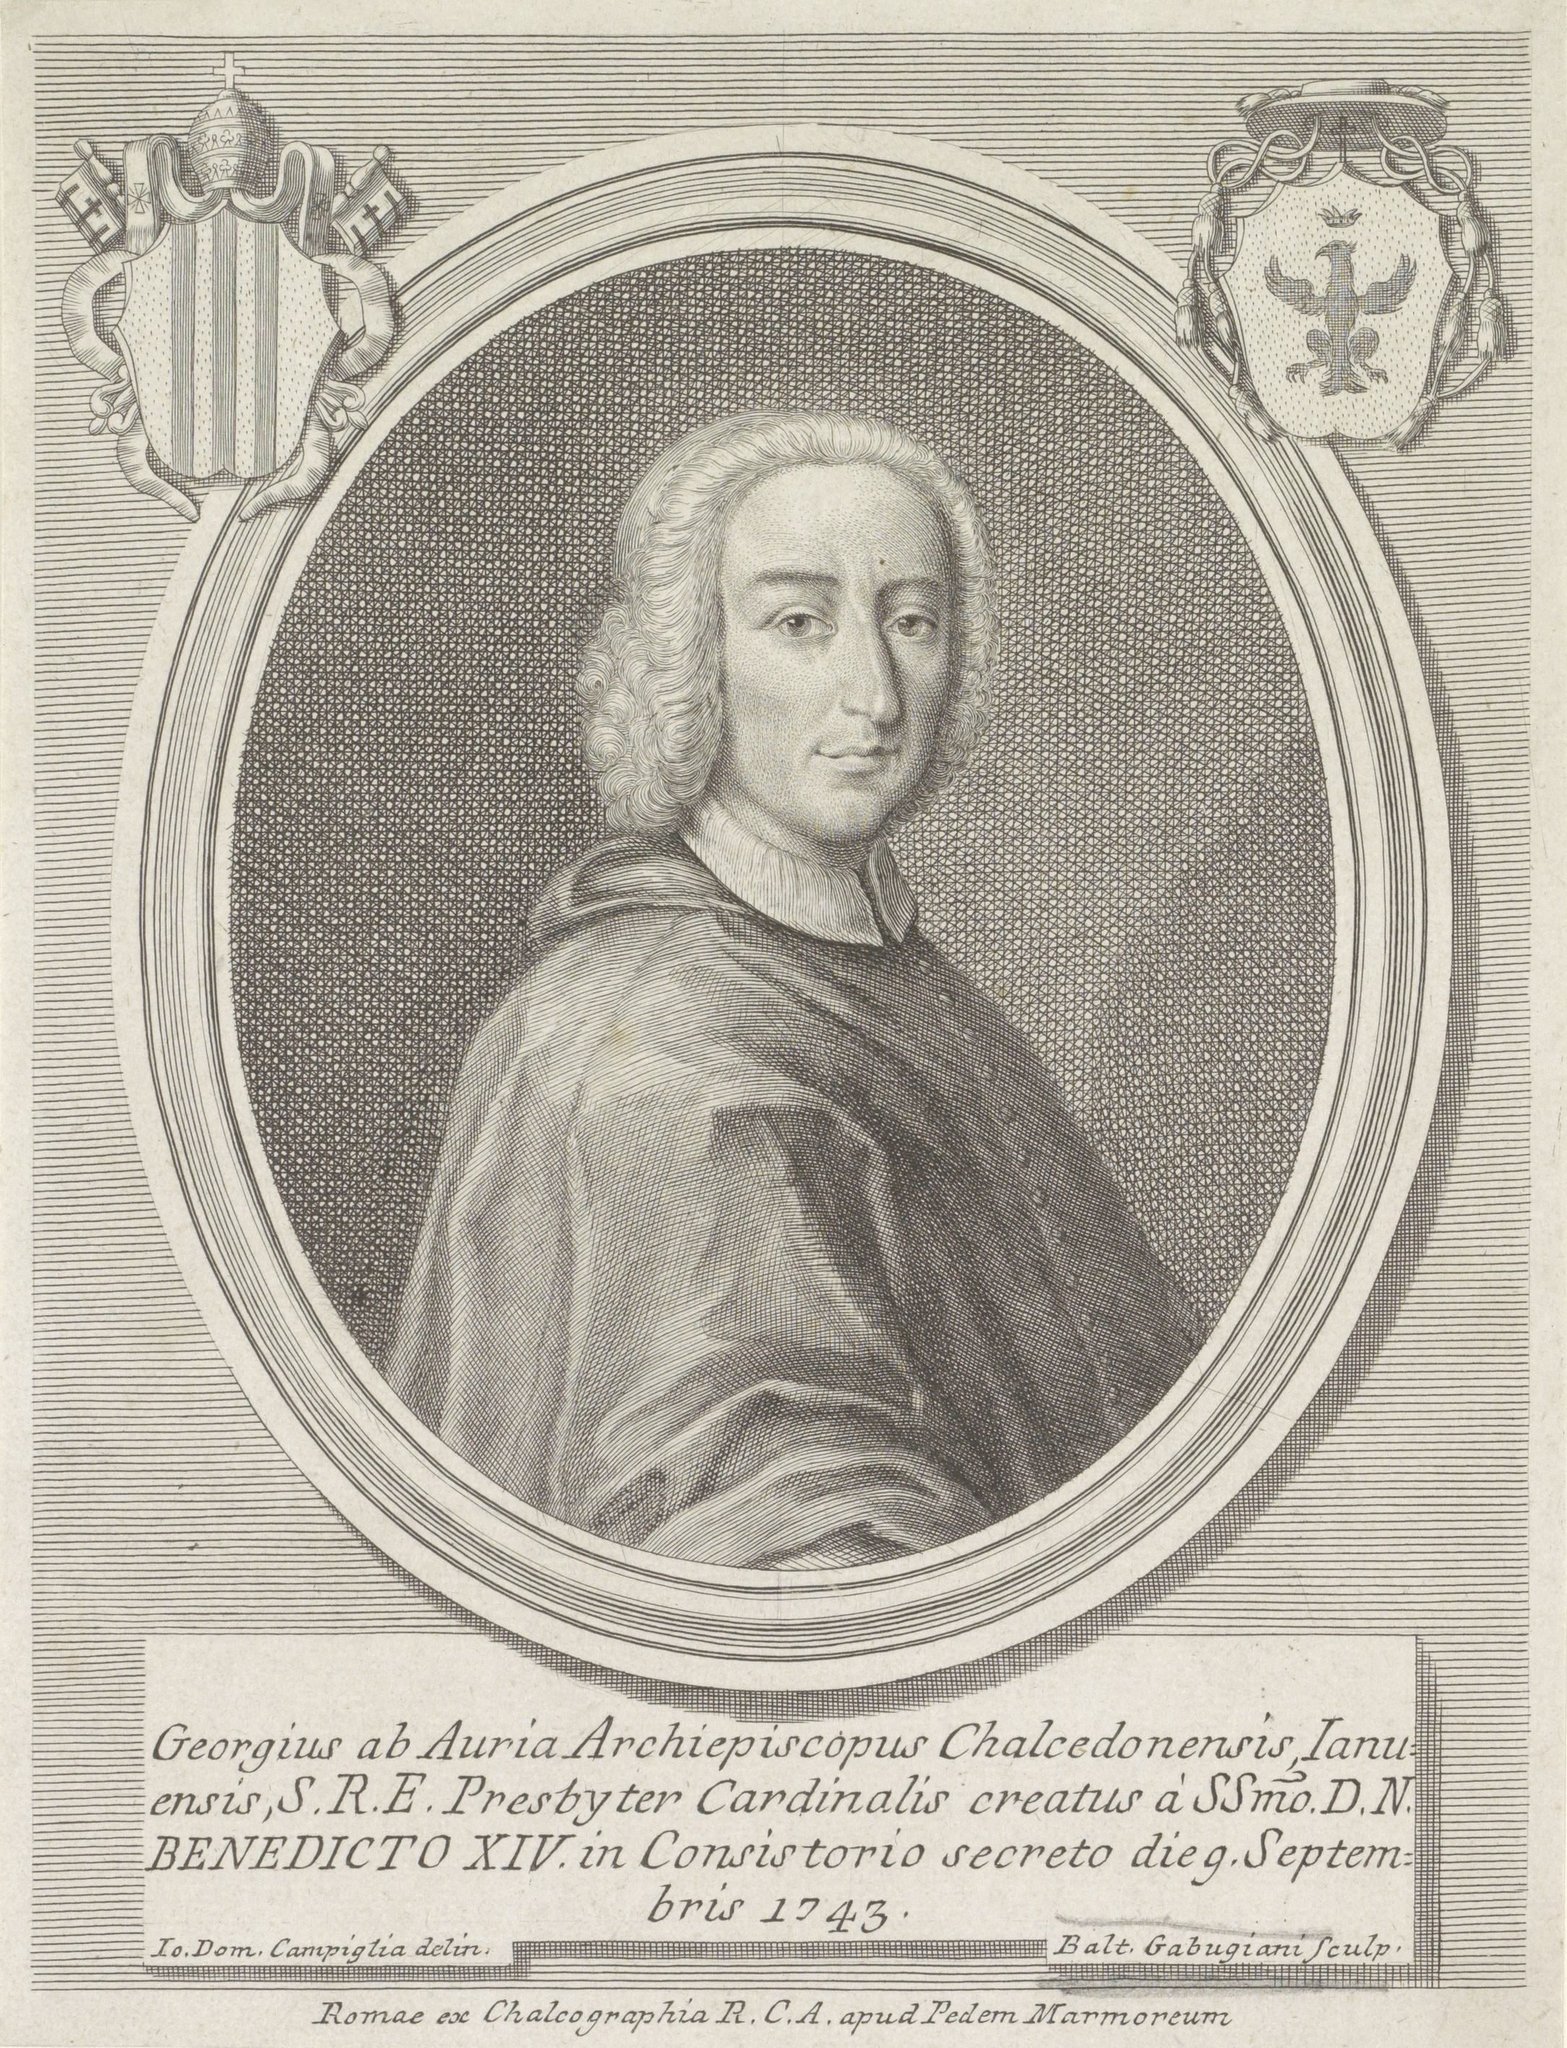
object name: print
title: Portret van kardinaal Giorgio Doria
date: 1743-1750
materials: paper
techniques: engraving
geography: italy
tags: cardinal, historical persons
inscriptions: collector's mark: Lugt 2228